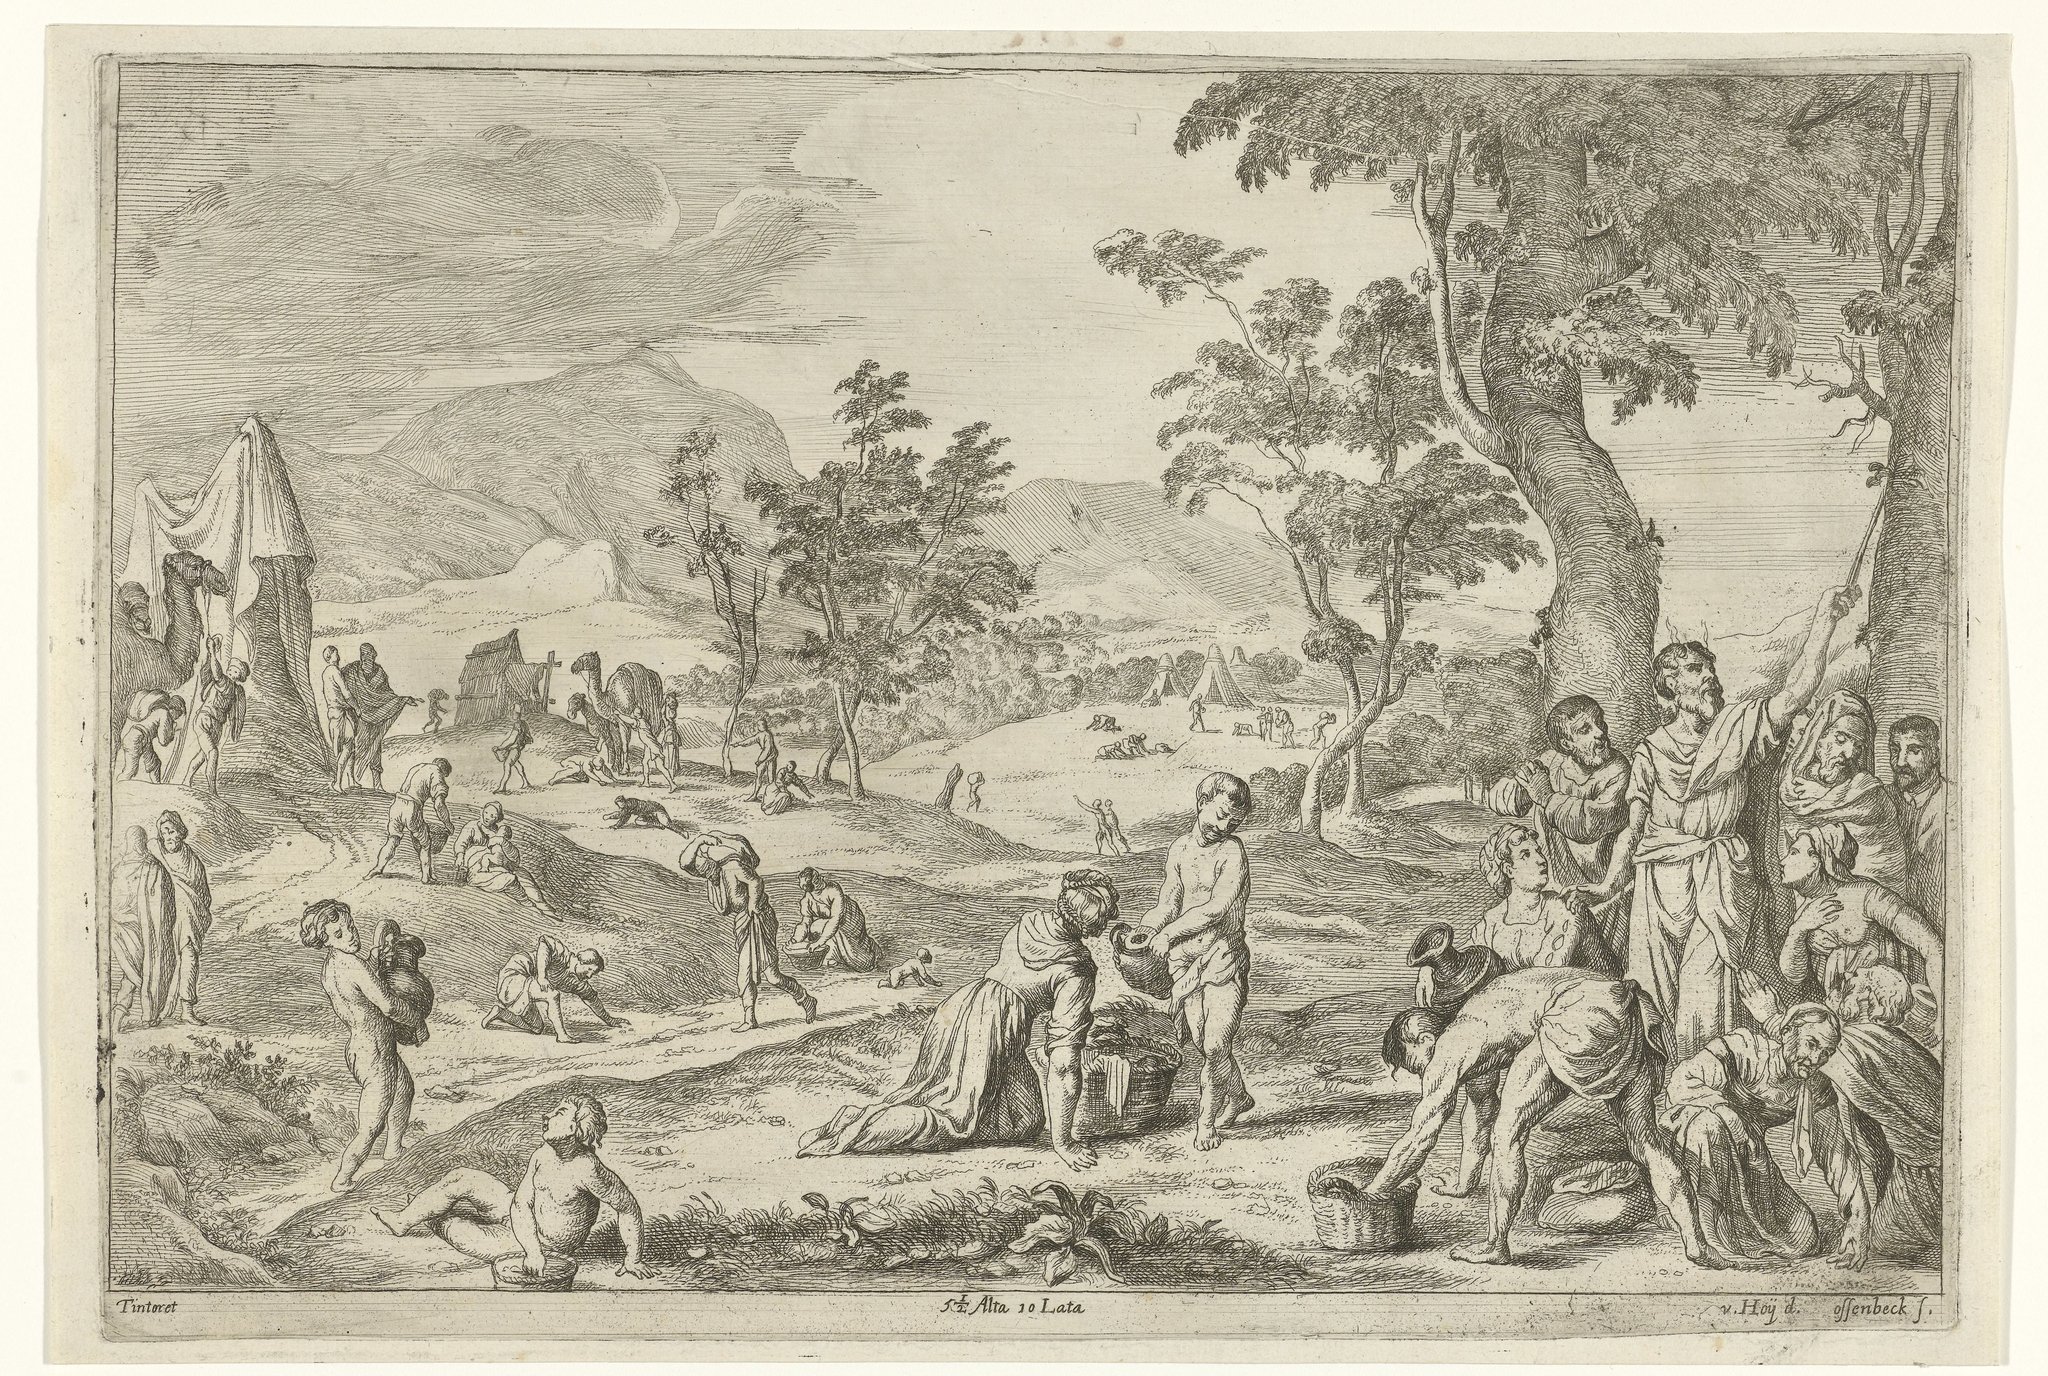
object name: print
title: Verzamelen van het manna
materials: paper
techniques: engraving, etching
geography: brussels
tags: the gathering of manna (in baskets and pots)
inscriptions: collector's mark: Lugt 270, collector's mark: Lugt 2228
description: Prent gemaakt als reproductie van een schilderij uit de collectie van aartshertog Leopold Willem van Oostenrijk te Brussel: David Teniers, Theatrum pictorum. Verschillende editites. Eerste editie uit 1660.